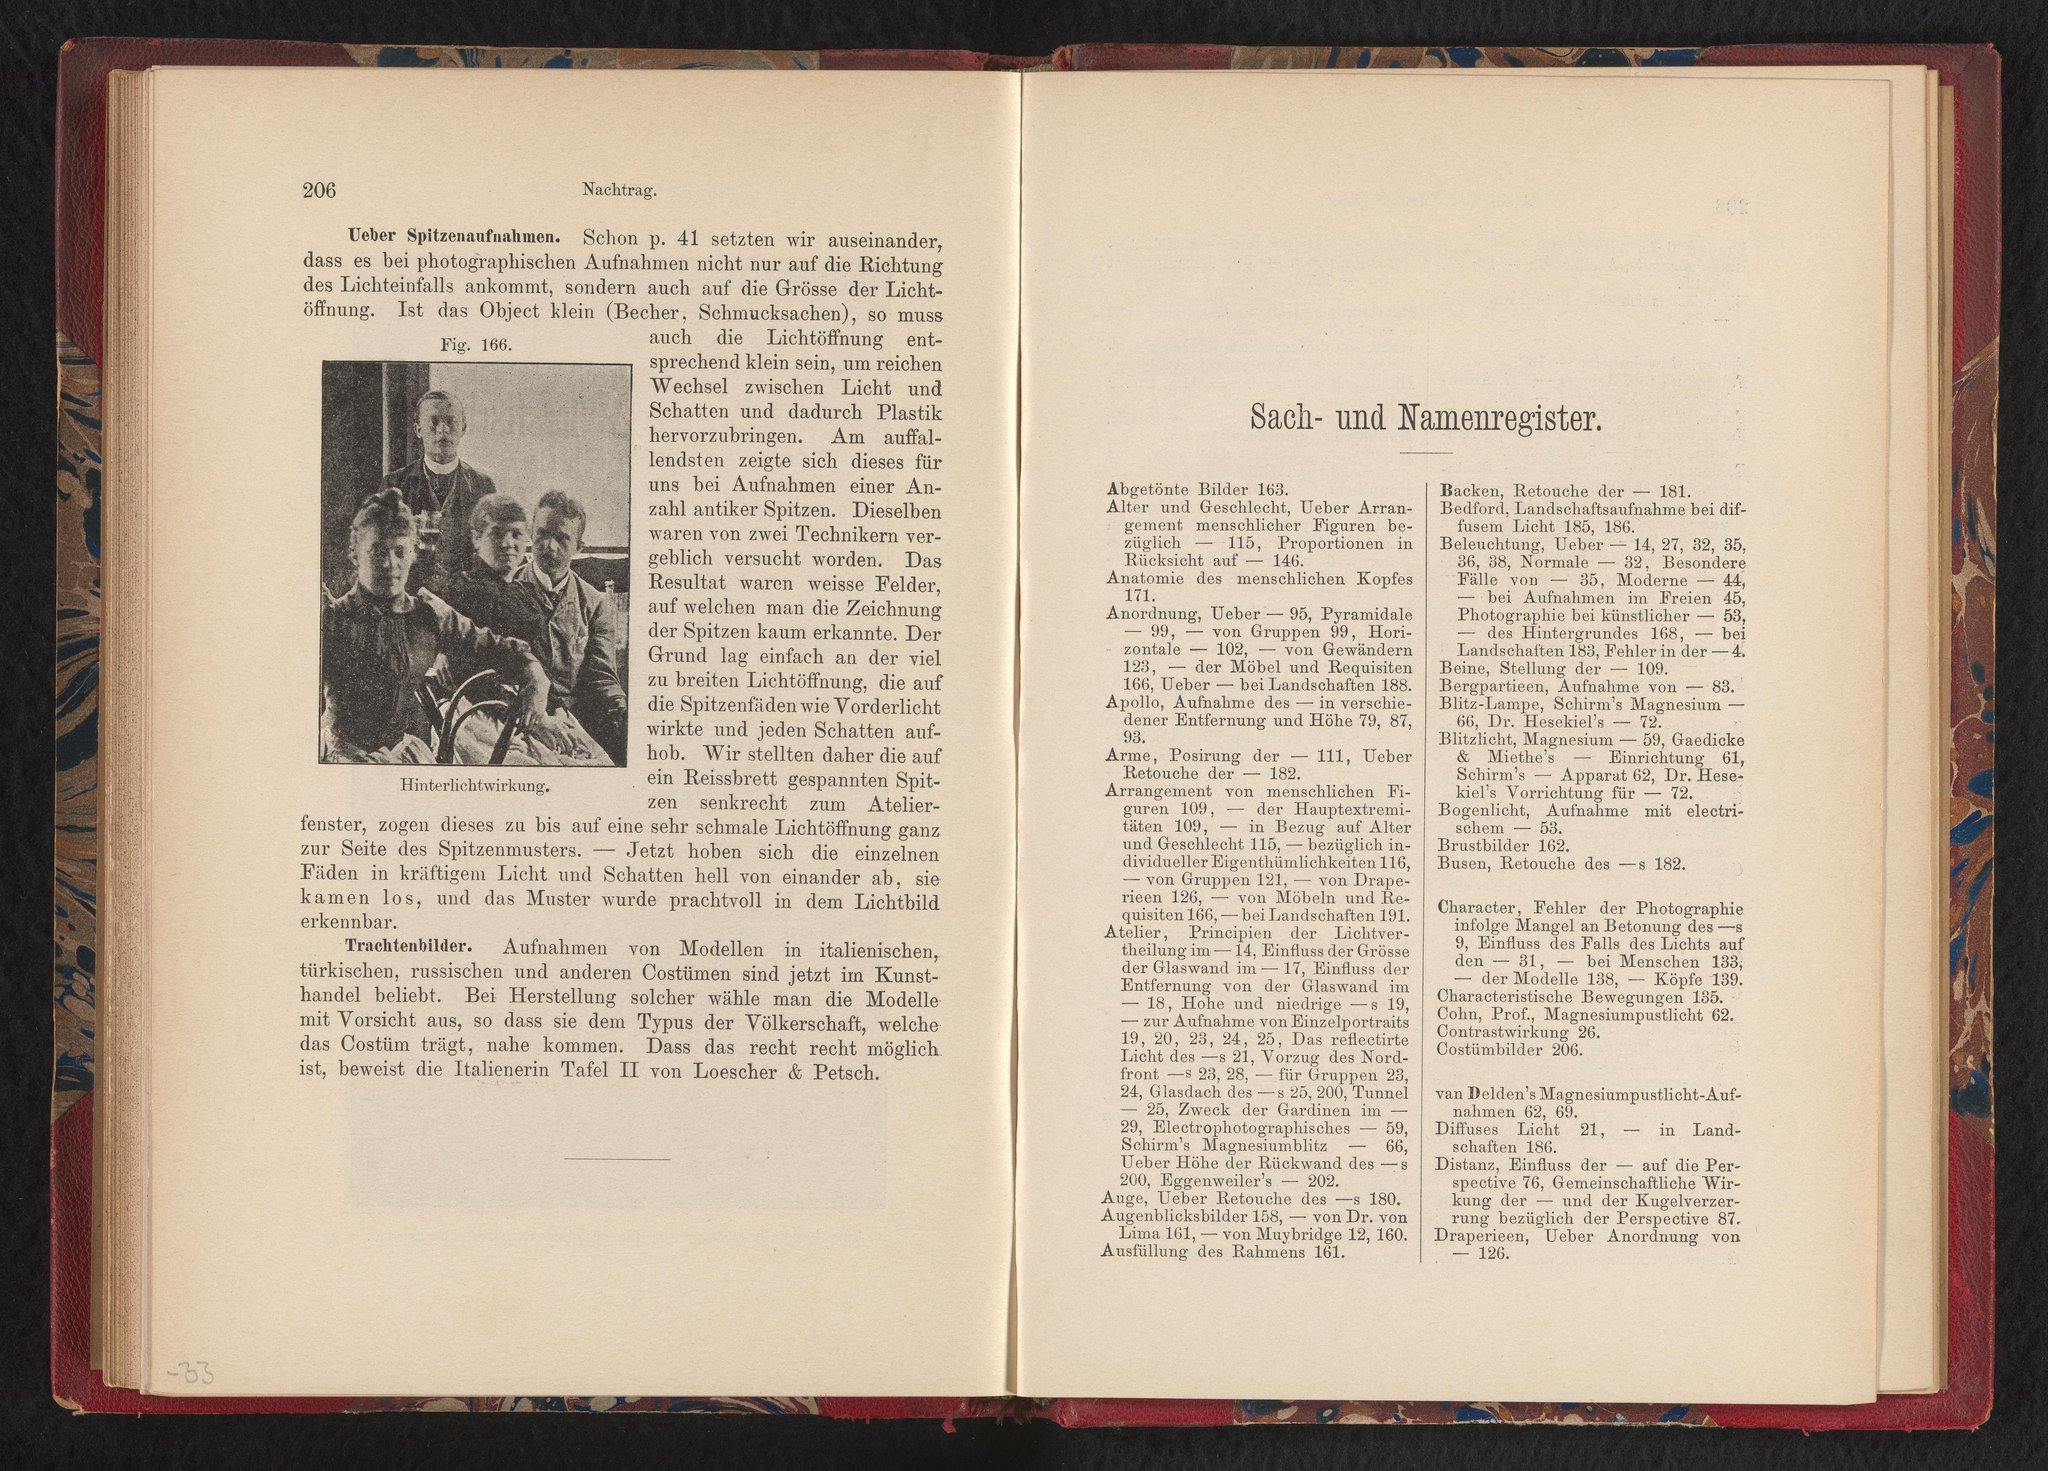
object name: photomechanical print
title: Portret van vier mensen, mogelijk in een café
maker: Anonymous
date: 1886-1891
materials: paper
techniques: autotype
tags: window, glass of beer, anonymous historical persons portrayed in a group, in a group-portrait